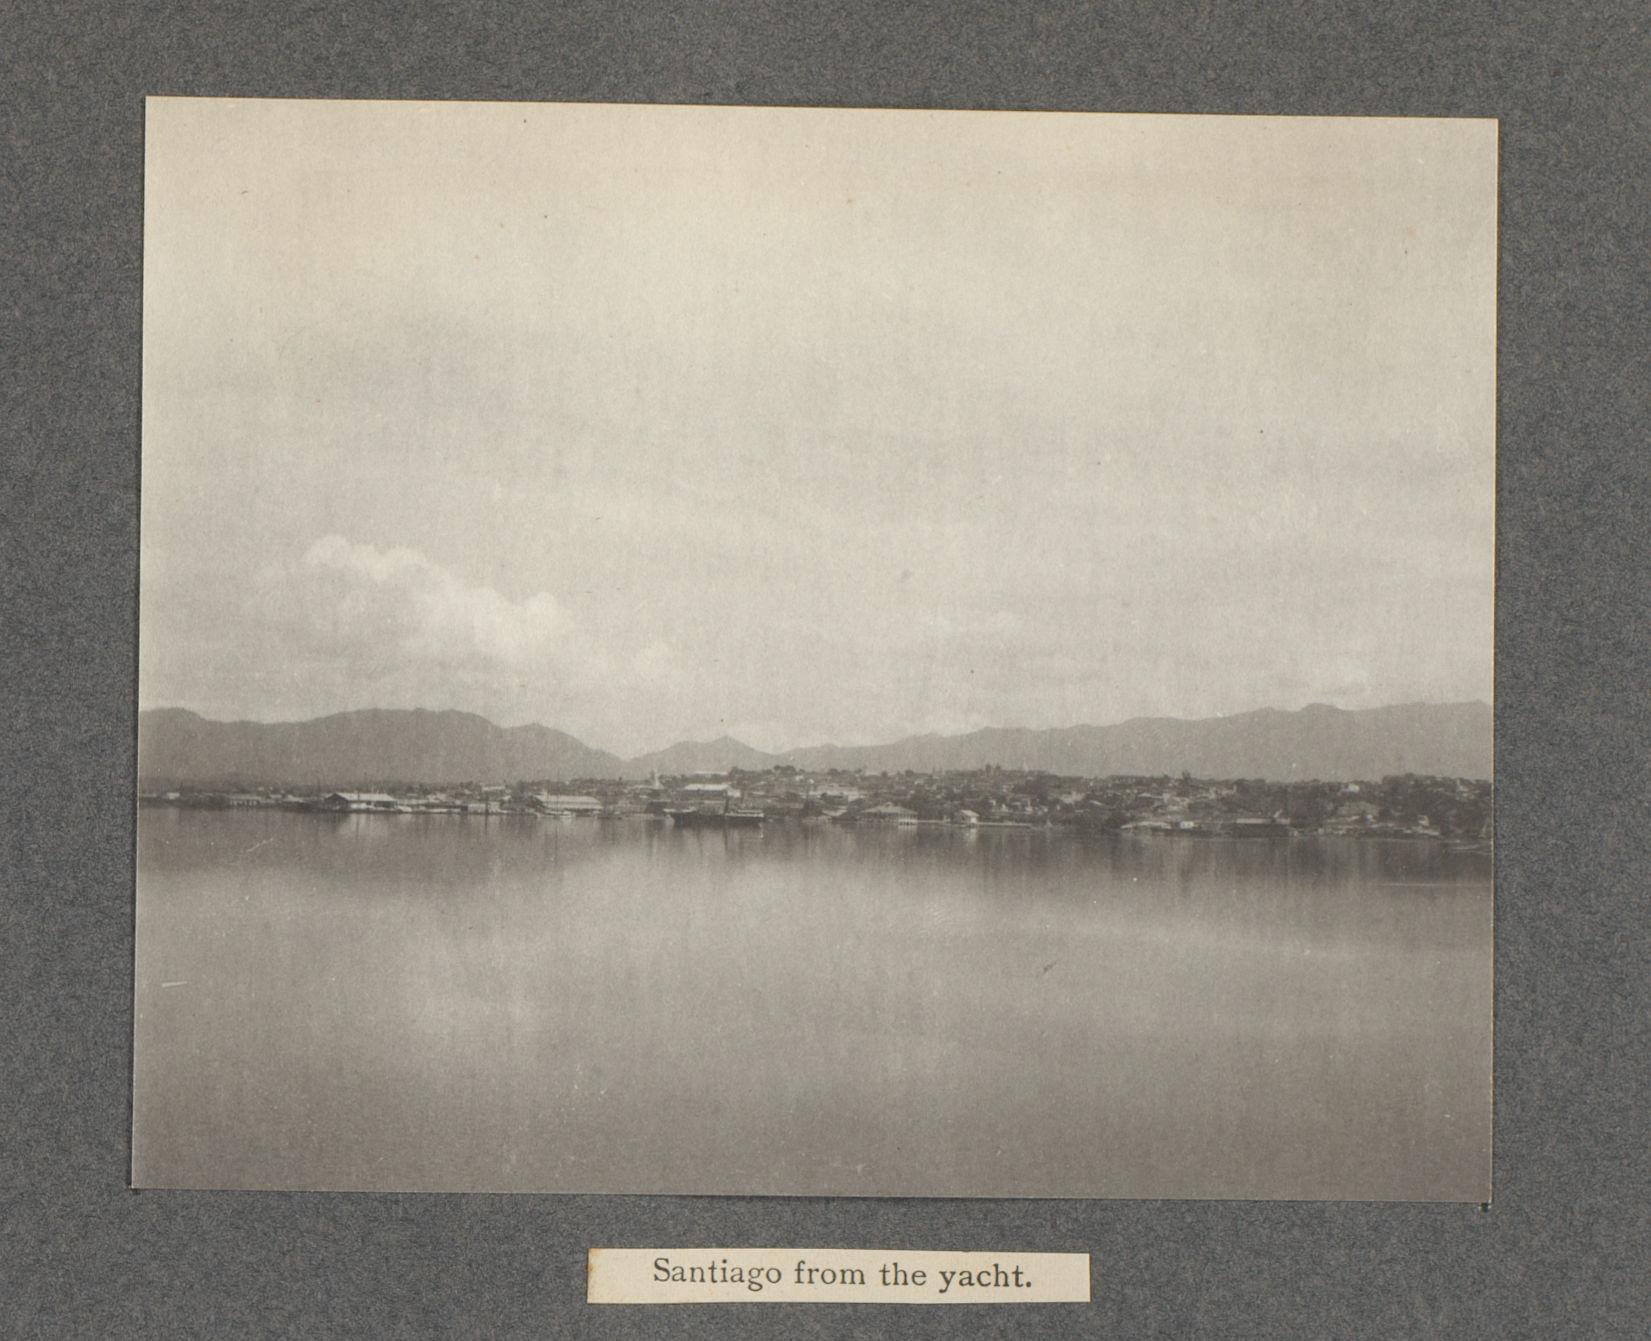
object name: photograph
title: Gezicht op Santiago vanuit de baai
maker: Anonymous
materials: paper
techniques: platinum process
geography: santiago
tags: gulf, bay, prospect of city, town panorama, silhouette of city